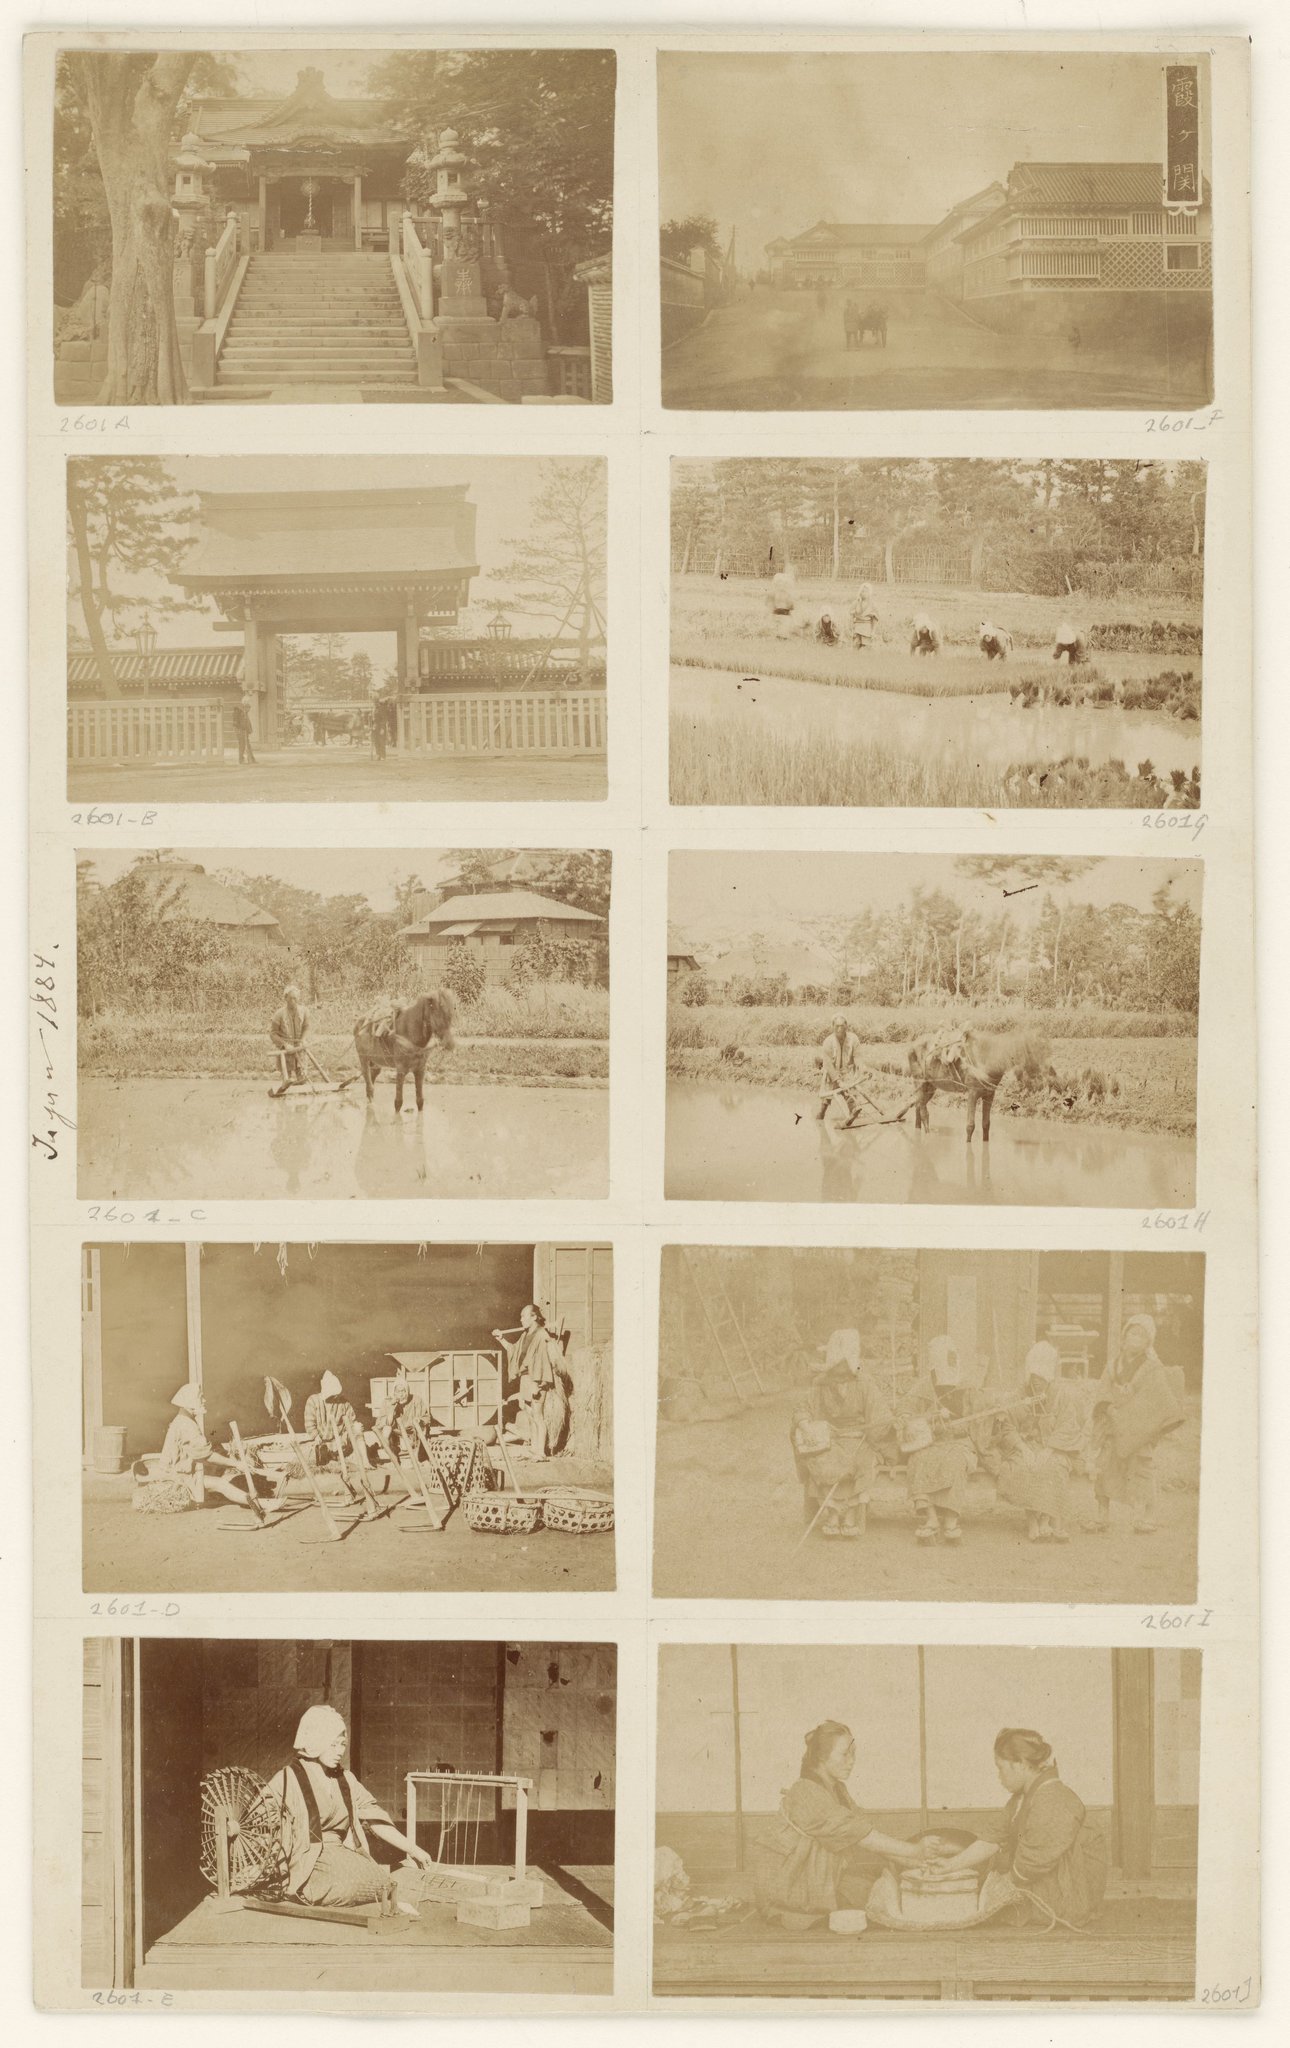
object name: photograph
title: Japanse vrouw spint wol met een spinnewiel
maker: Anonymous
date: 1884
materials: cardboard, paper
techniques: albumen print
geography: japan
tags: spinning-wheel, japan